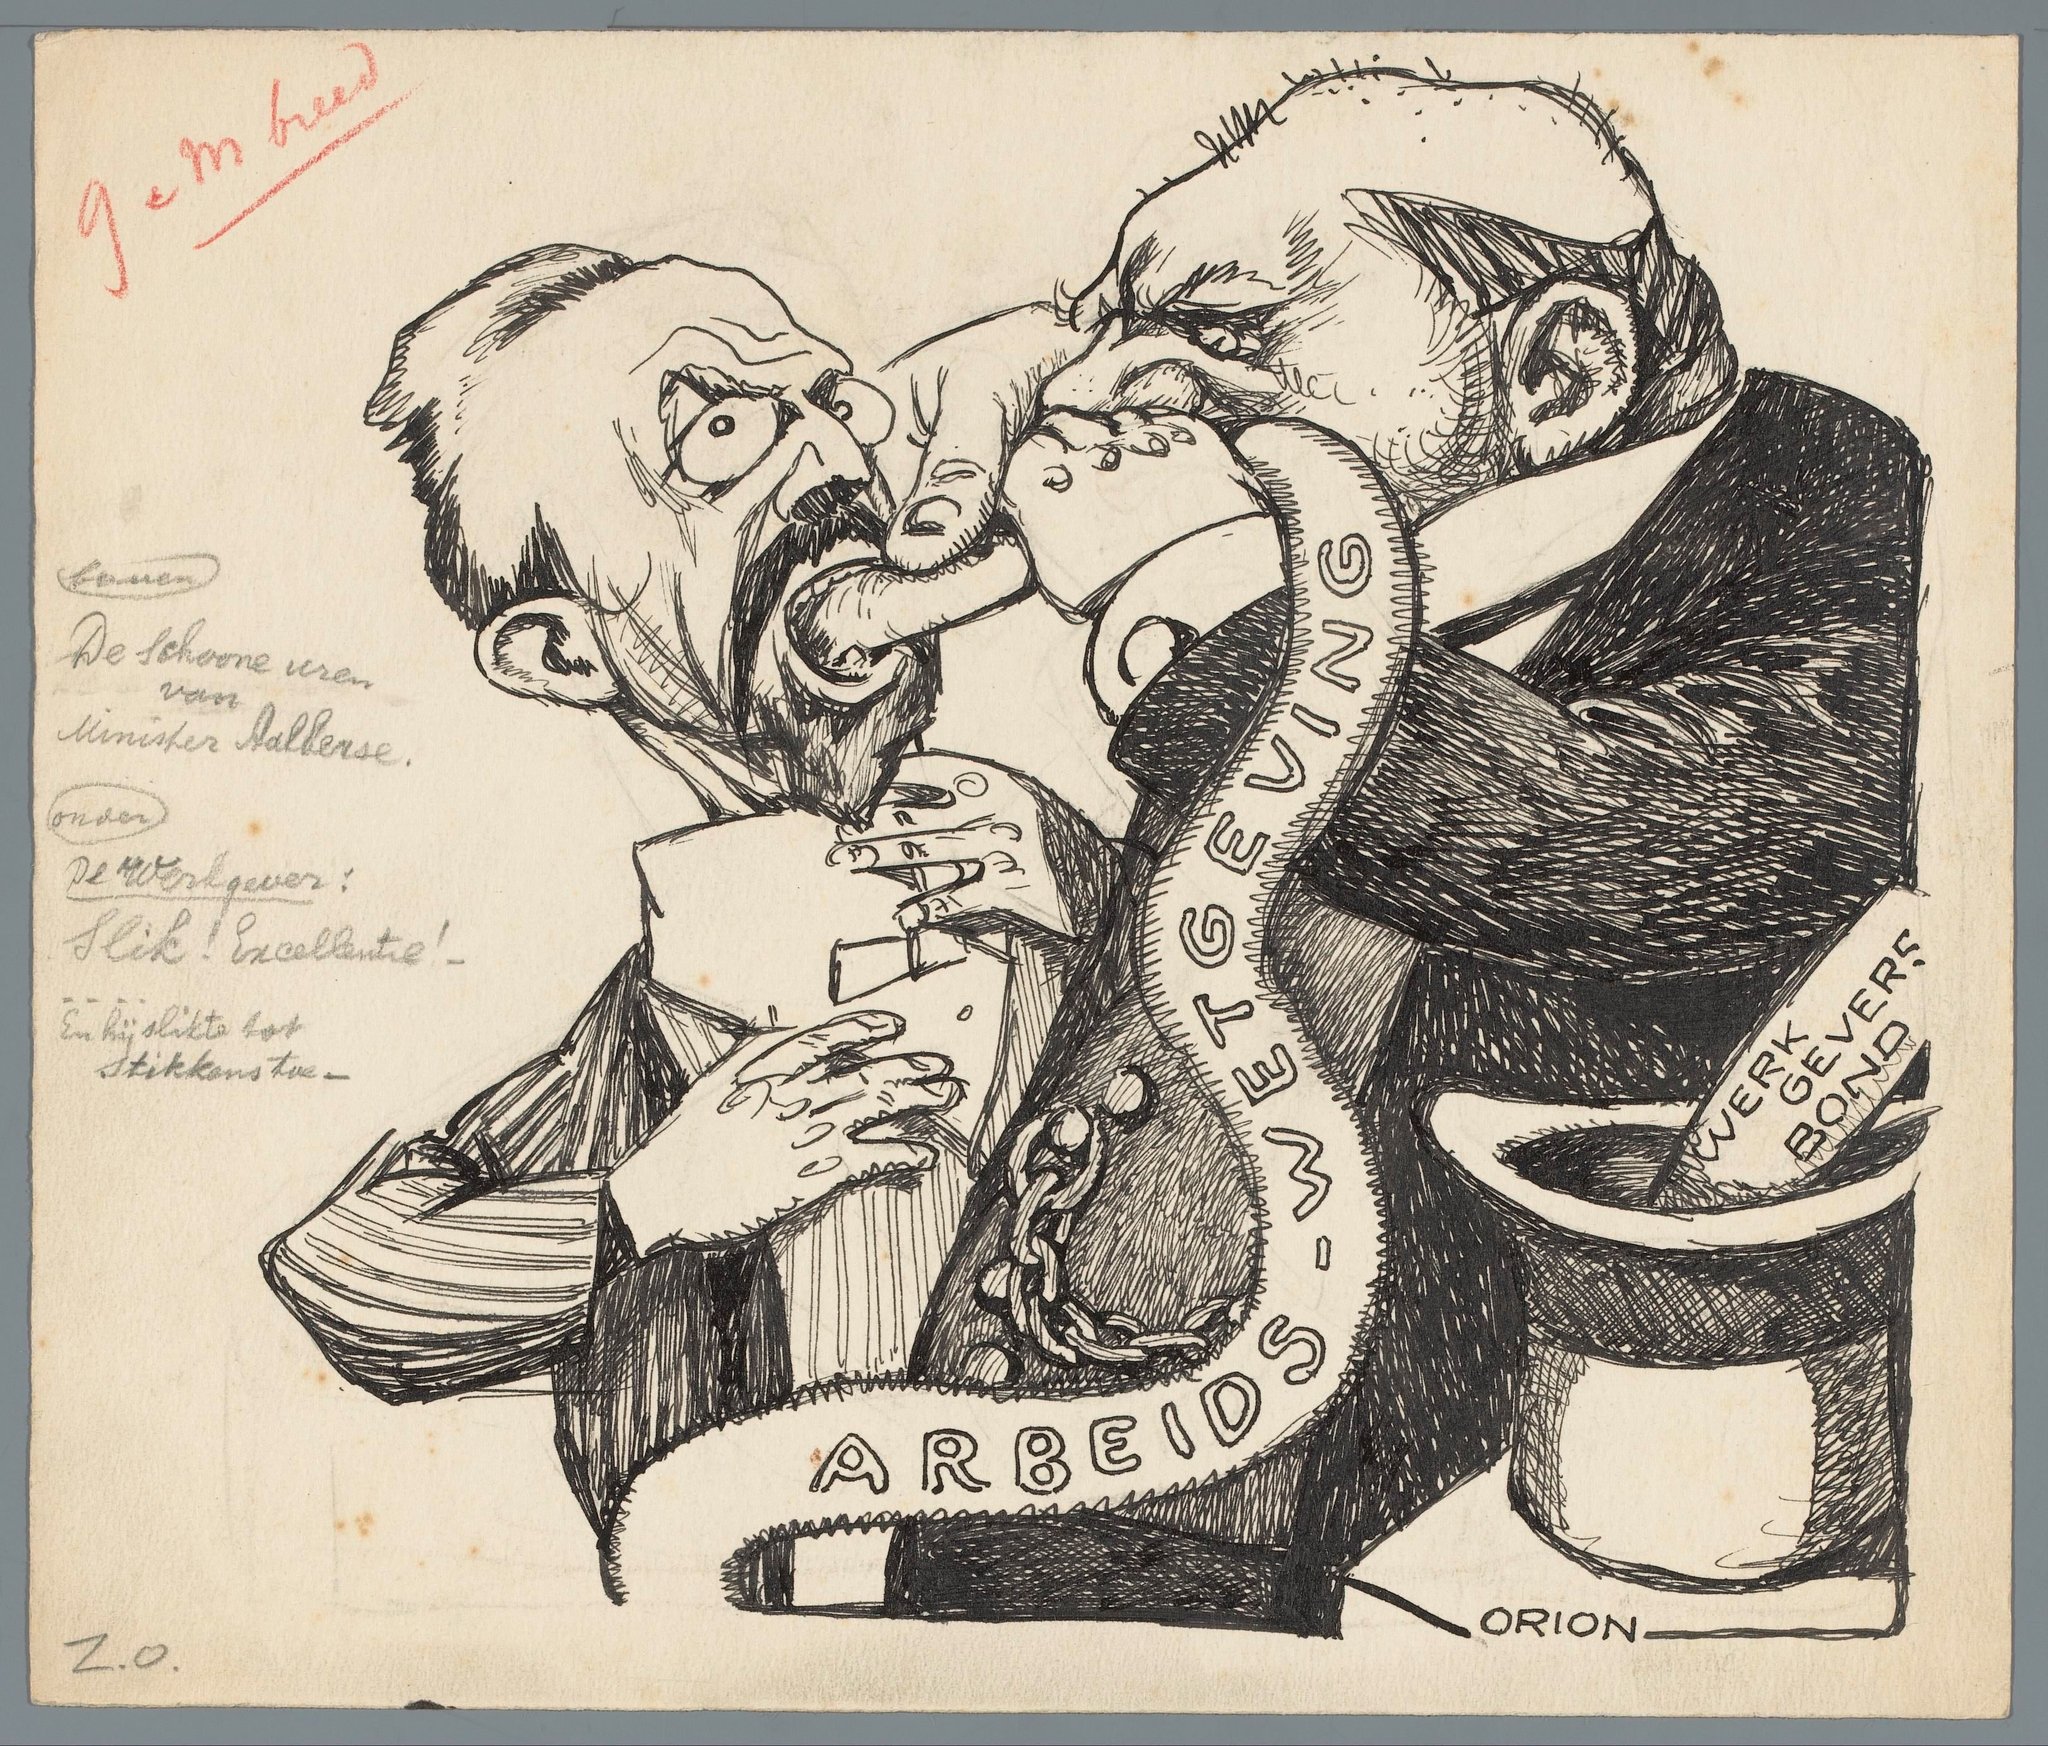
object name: drawing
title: De schone veren van Minister Aalberse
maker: patricq kroon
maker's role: draughtsman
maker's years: 1862-1941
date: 1918-1925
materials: ink, paper, pencil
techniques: pen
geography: netherlands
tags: leiden, politician, political caricatures and satires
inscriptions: inscription: ‘De schone veren van Minister Aalberse / De Werkgever: Slik ! Excellentie ! ... En hij slikte tot stikkens toe’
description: Een vertegenwoordiger van de werkgeversbond duwt een slang 'arbeids-wetgeving' in de keel van minister Aalberse van Arbeid. Ontwerp voor een politieke spotprent.